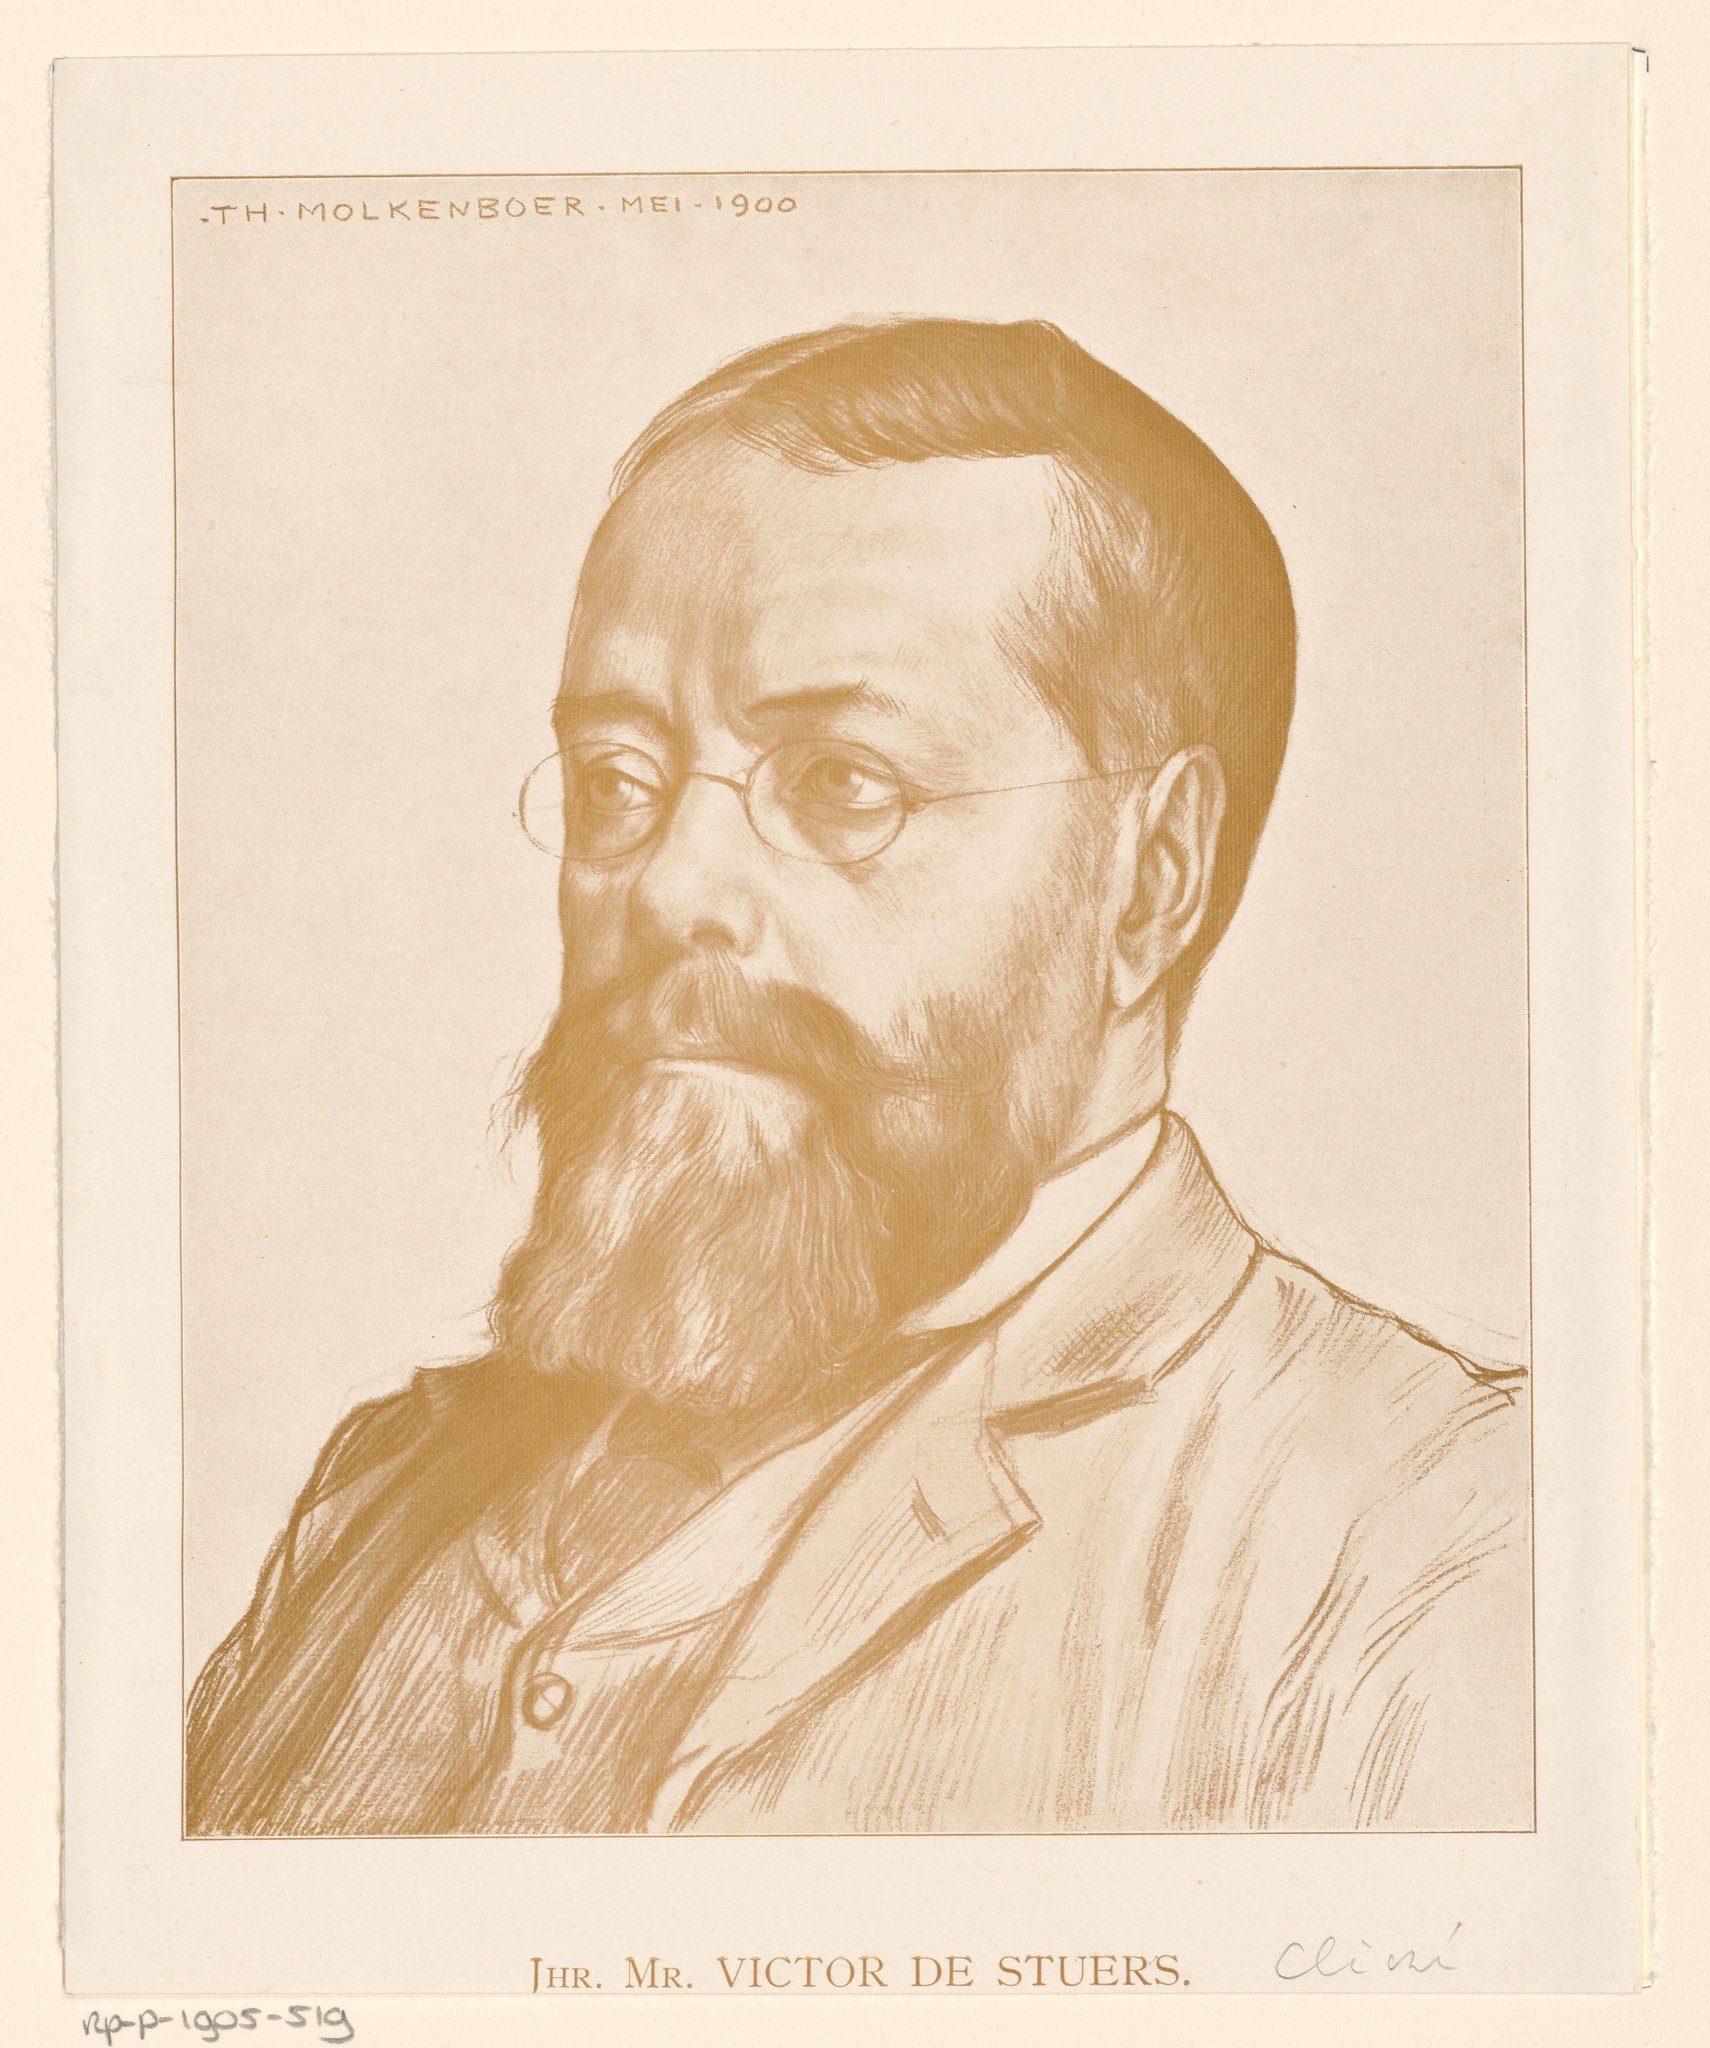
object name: photomechanical print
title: Portret van Victor de Stuers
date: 1900-1901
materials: paper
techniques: autotype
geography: netherlands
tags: maastricht, the hague, politician, victor de stuers, historical persons, politician, e.g. party leader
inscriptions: collector's mark: Lugt 2228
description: Prent uit: Maandblad voor het Teekenonderwijs. Jrg.17, 2. (1900-1901).